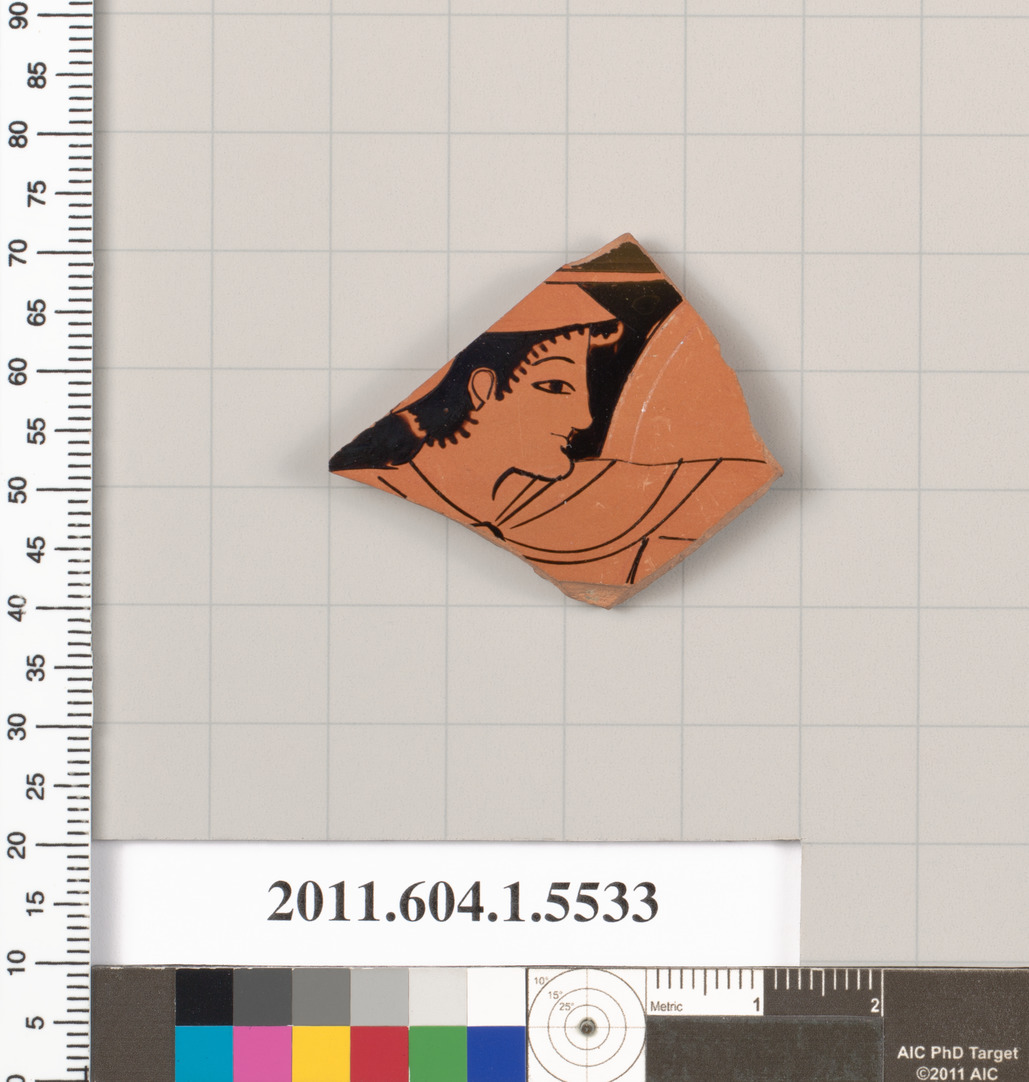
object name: kylix fragment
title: Terracotta fragment of a kylix (drinking cup)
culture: greek, attic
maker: nikosthenes painter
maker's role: artist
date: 534-501 BCE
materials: terracotta